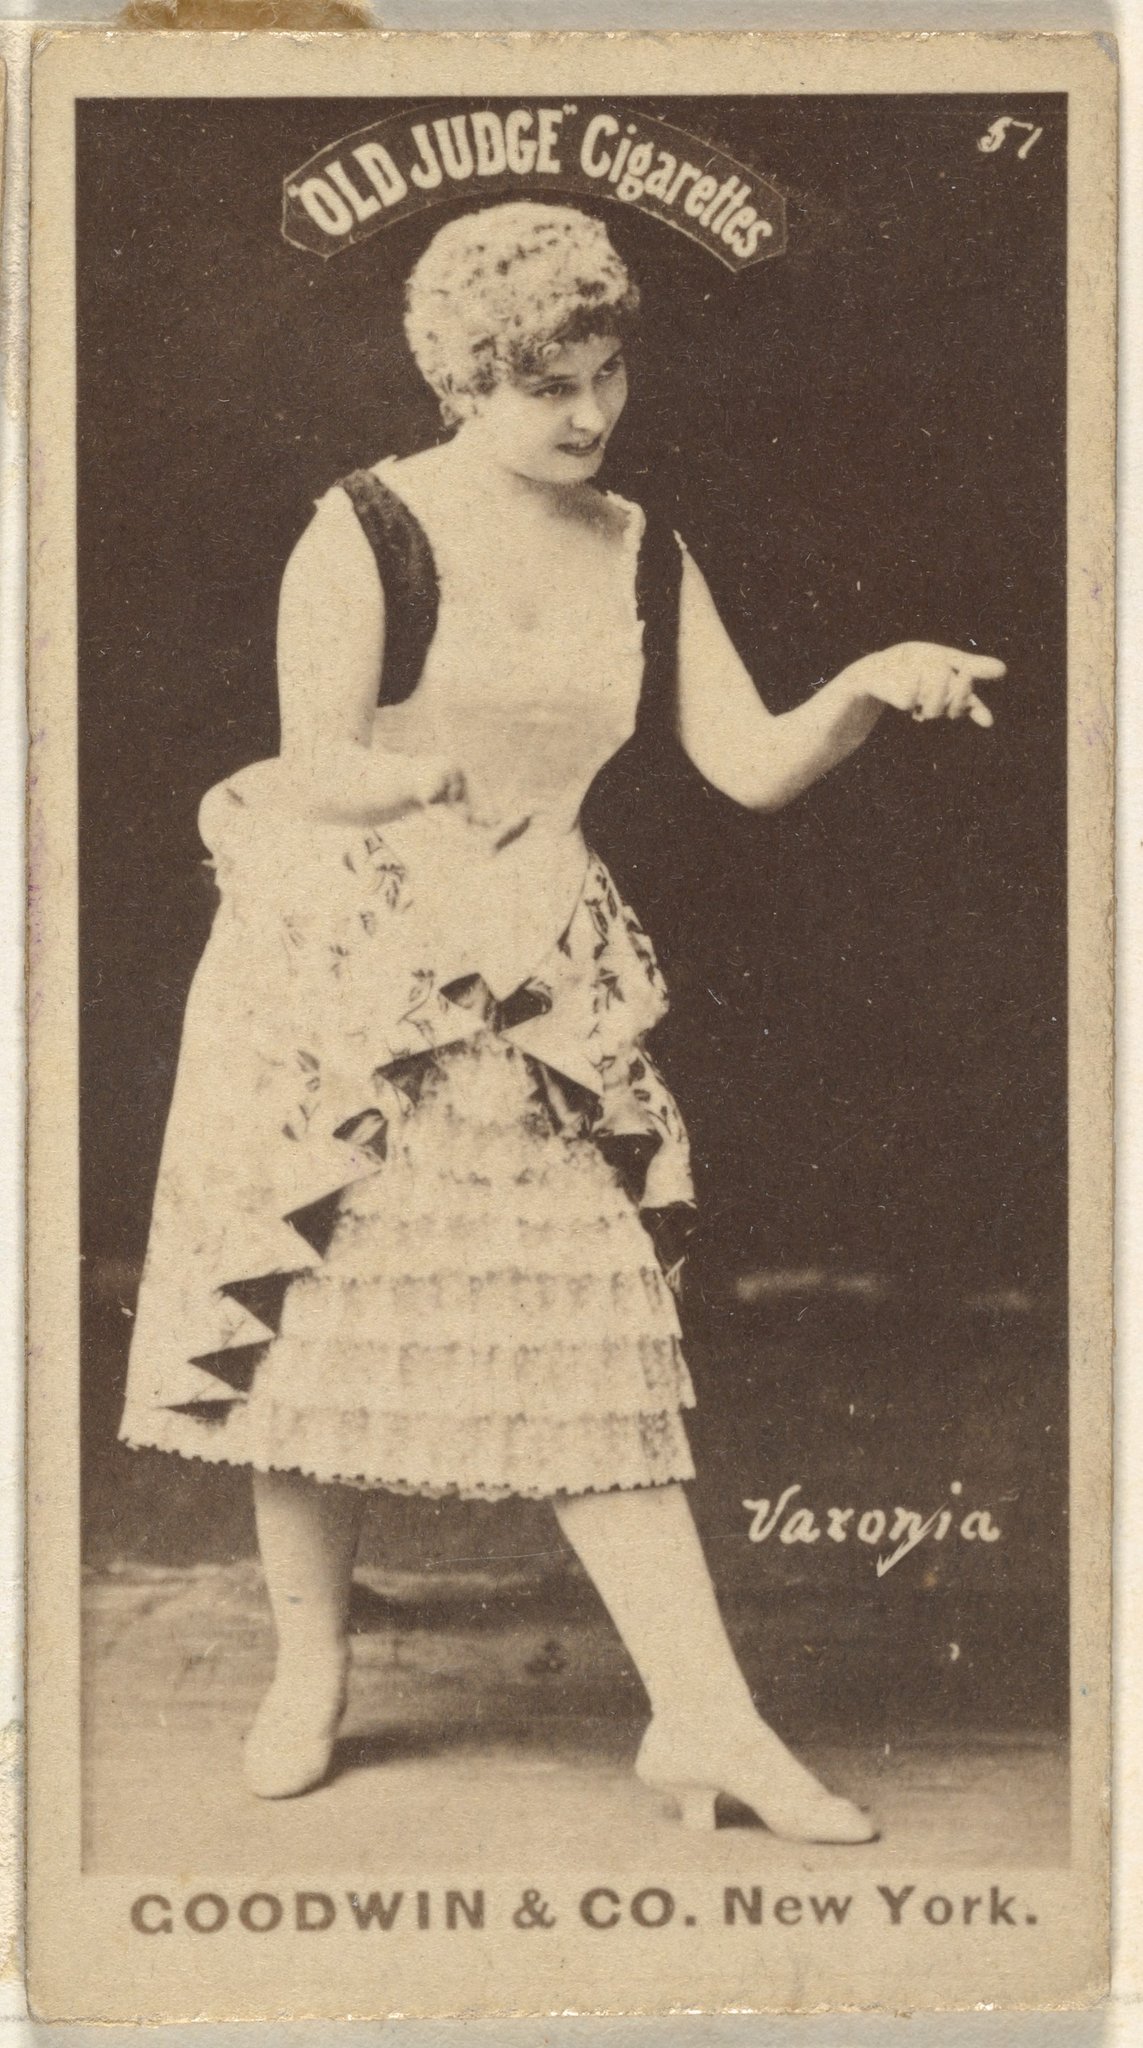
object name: photograph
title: Varonia, from the Actors and Actresses series (N171) for Old Judge Cigarettes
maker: goodwin & company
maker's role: publisher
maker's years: 1850-1950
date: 1886-1890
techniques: albumen silver print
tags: portraits,women,actresses